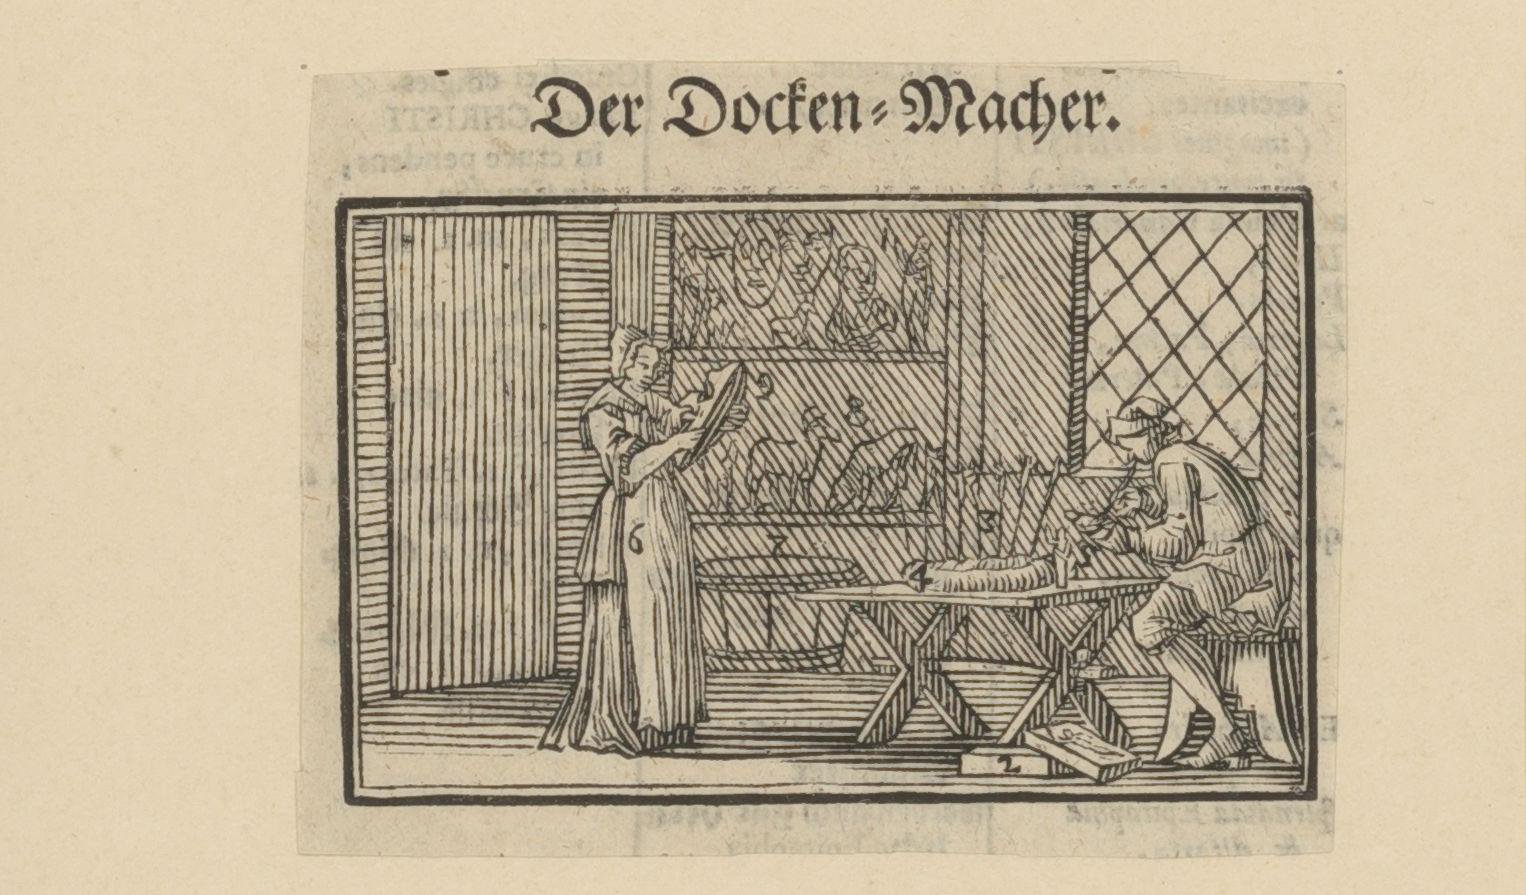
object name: print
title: Der Docken-Macher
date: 1719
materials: paper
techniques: letterpress printing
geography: nuremberg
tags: handicrafts, craftsman at work, (playing with) toy animals, (playing with) dolls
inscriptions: collector's mark: Lugt 1641, stamp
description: Een werkplaats waar een poppenmaker uit dragant poppen maakt. Op de grond een kuip met papier-maché waarmee hij beesten en maskers maakt. Op de achtergrond een kast met zijn producten die worden verkocht. Onderwerpsrubrieken binnen de Atlas Zeden en Gewoonten: Handel, Nijverheid en Verkeer, Beroep en bedrijf, Complete suites.